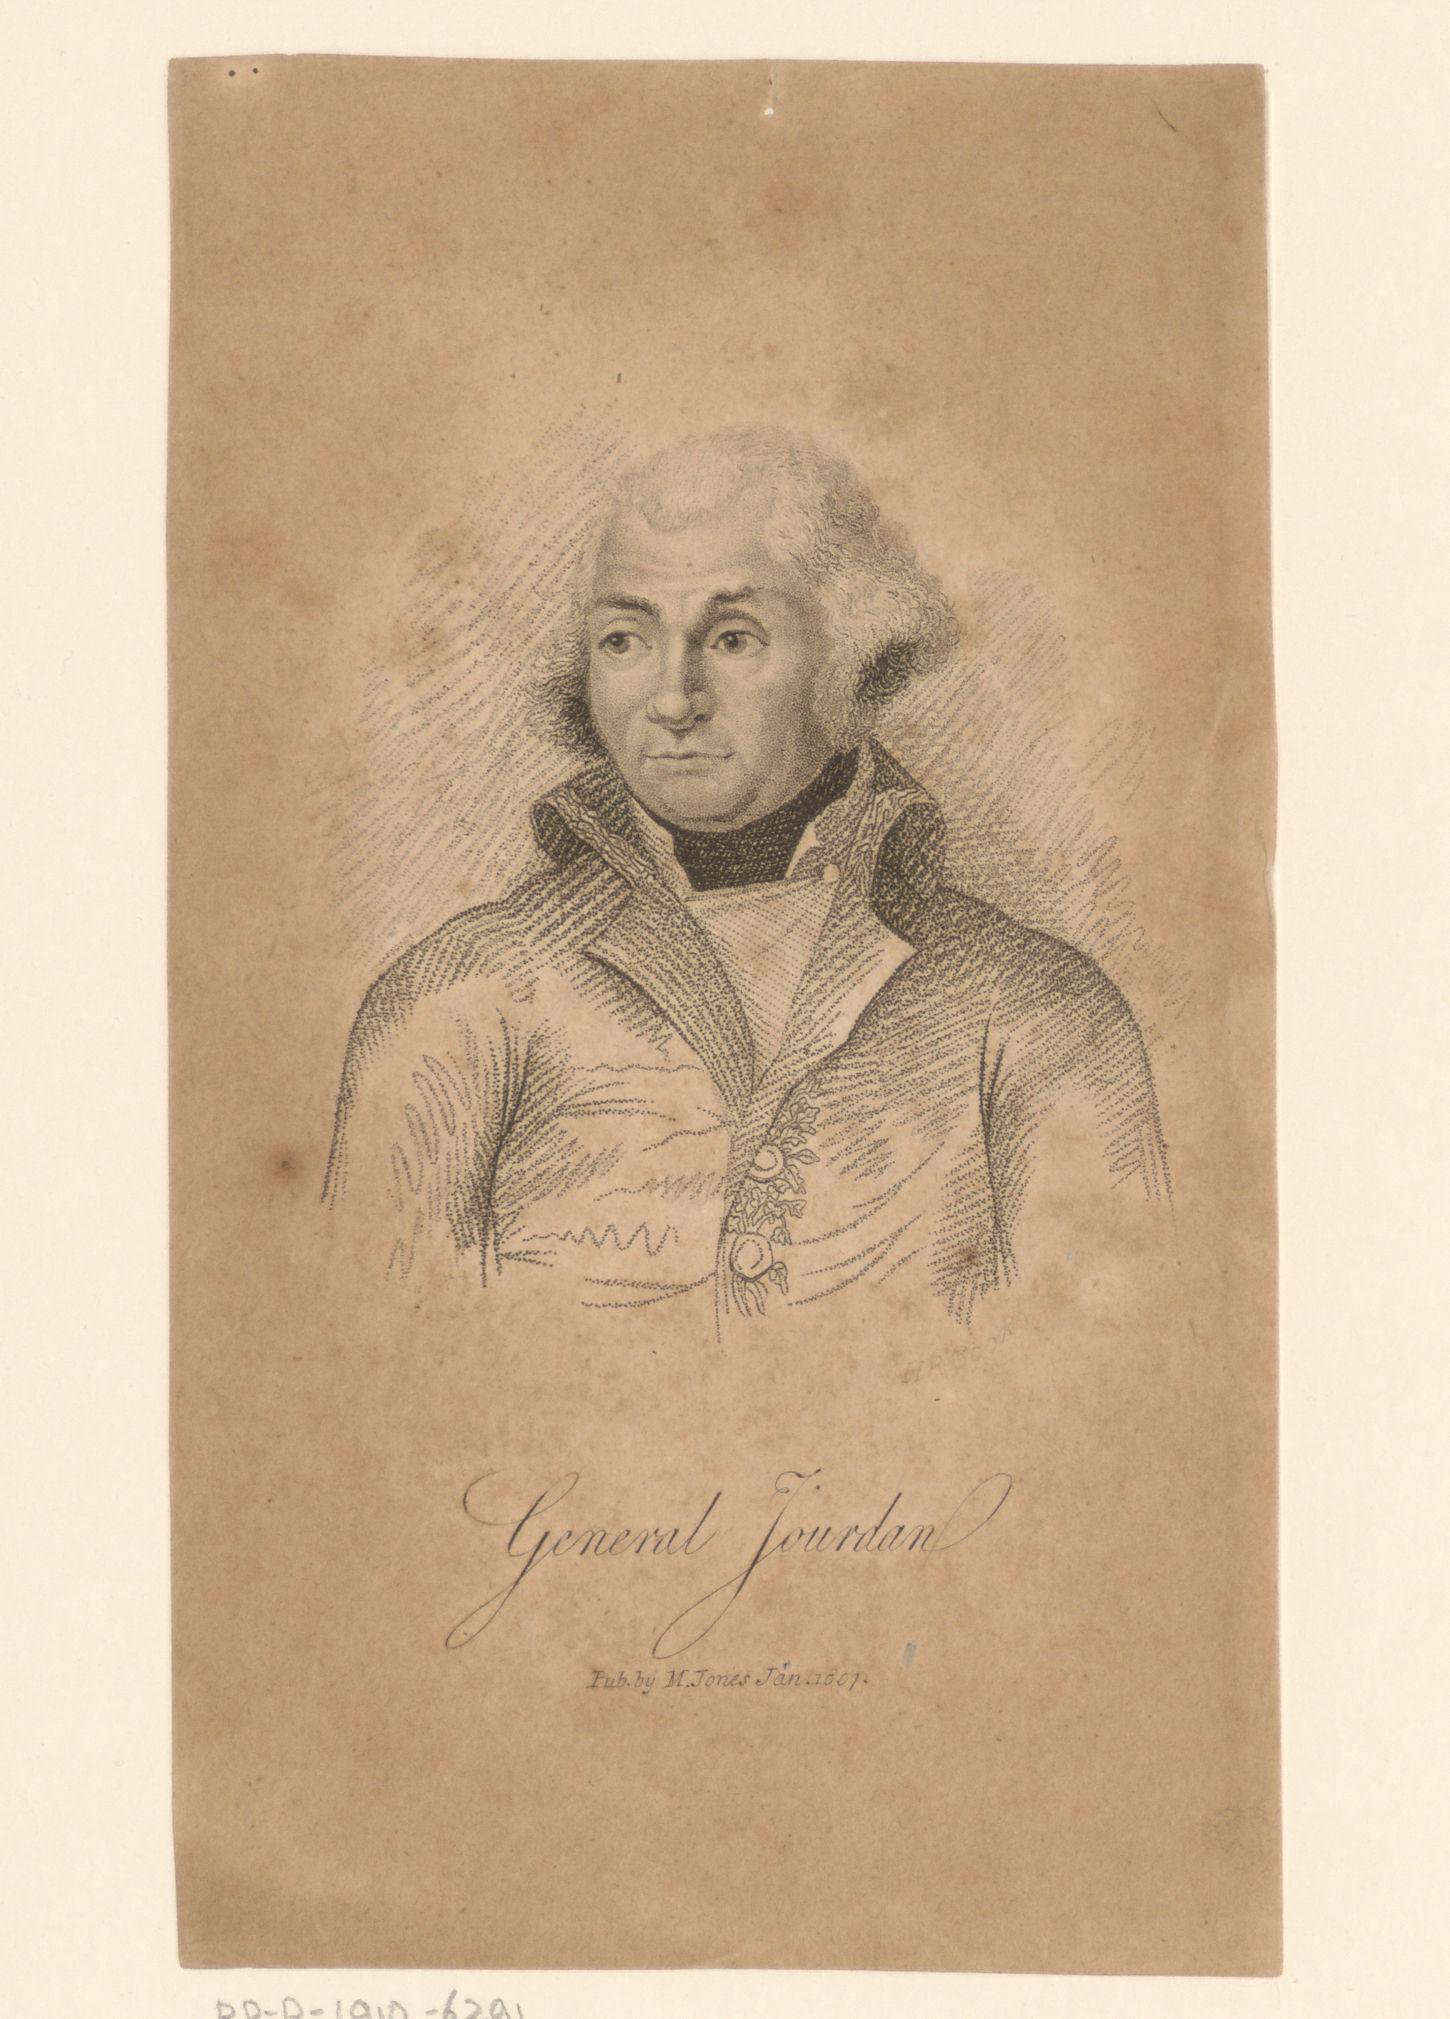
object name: print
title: Portret van Jean-Baptiste Jourdan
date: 1801-1807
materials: paper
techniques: printmaking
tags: paris, politician, historical persons, politician, e.g. party leader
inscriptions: collector's mark: Lugt 2228